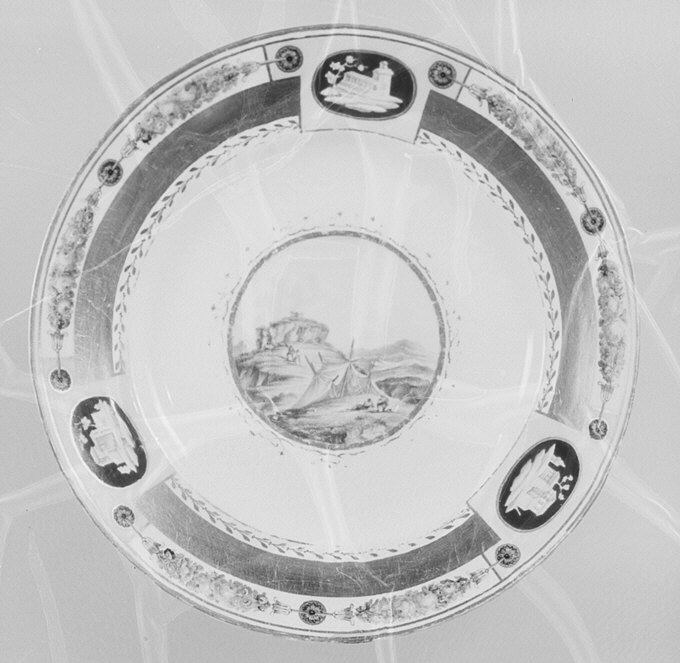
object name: plate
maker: imperial porcelain manufactory, st. petersburg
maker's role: manufactory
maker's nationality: russian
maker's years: 1744-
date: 1801-1804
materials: hard paste porcelain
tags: tents